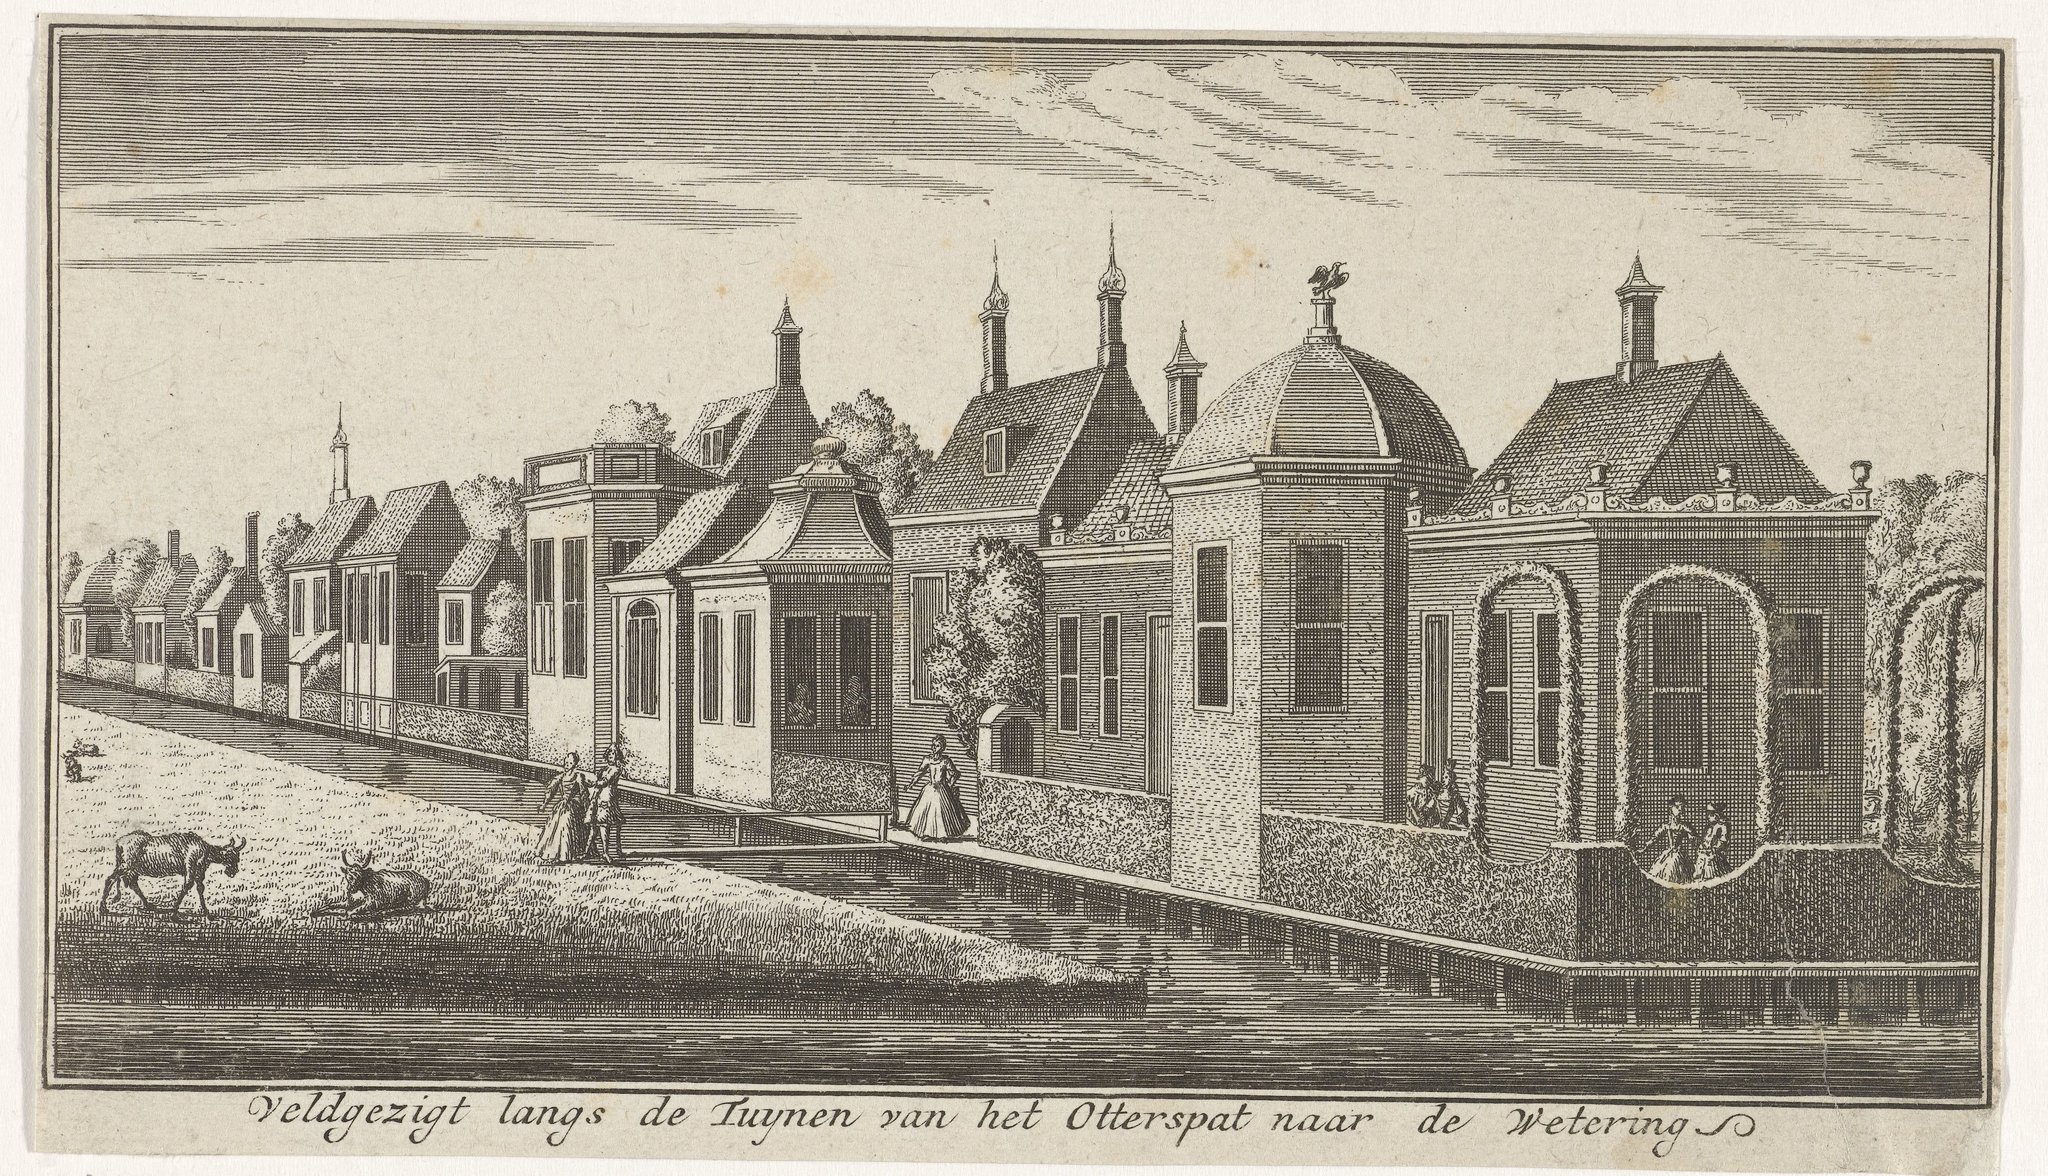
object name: print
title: Gezicht op de tuinen bij het Otterspad aan een wetering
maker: gerardus condet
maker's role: print maker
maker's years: 1715-1764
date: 1725-1764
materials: paper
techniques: etching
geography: amsterdam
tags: garden, bridge, goat, amsterdam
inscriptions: collector's mark: Lugt 2228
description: Gezicht op de tuinen bij het Otterspad aan een wetering, te Amsterdam. Over het kanaal loopt een brug die de tuinen - met hun sierlijke huisjes - en het grasveld met elkaar in verbinding brengt. Aan beide zijden van de brug staan elegant geklede figuren en op het gras bij het water bevindt zich een aantal geiten.